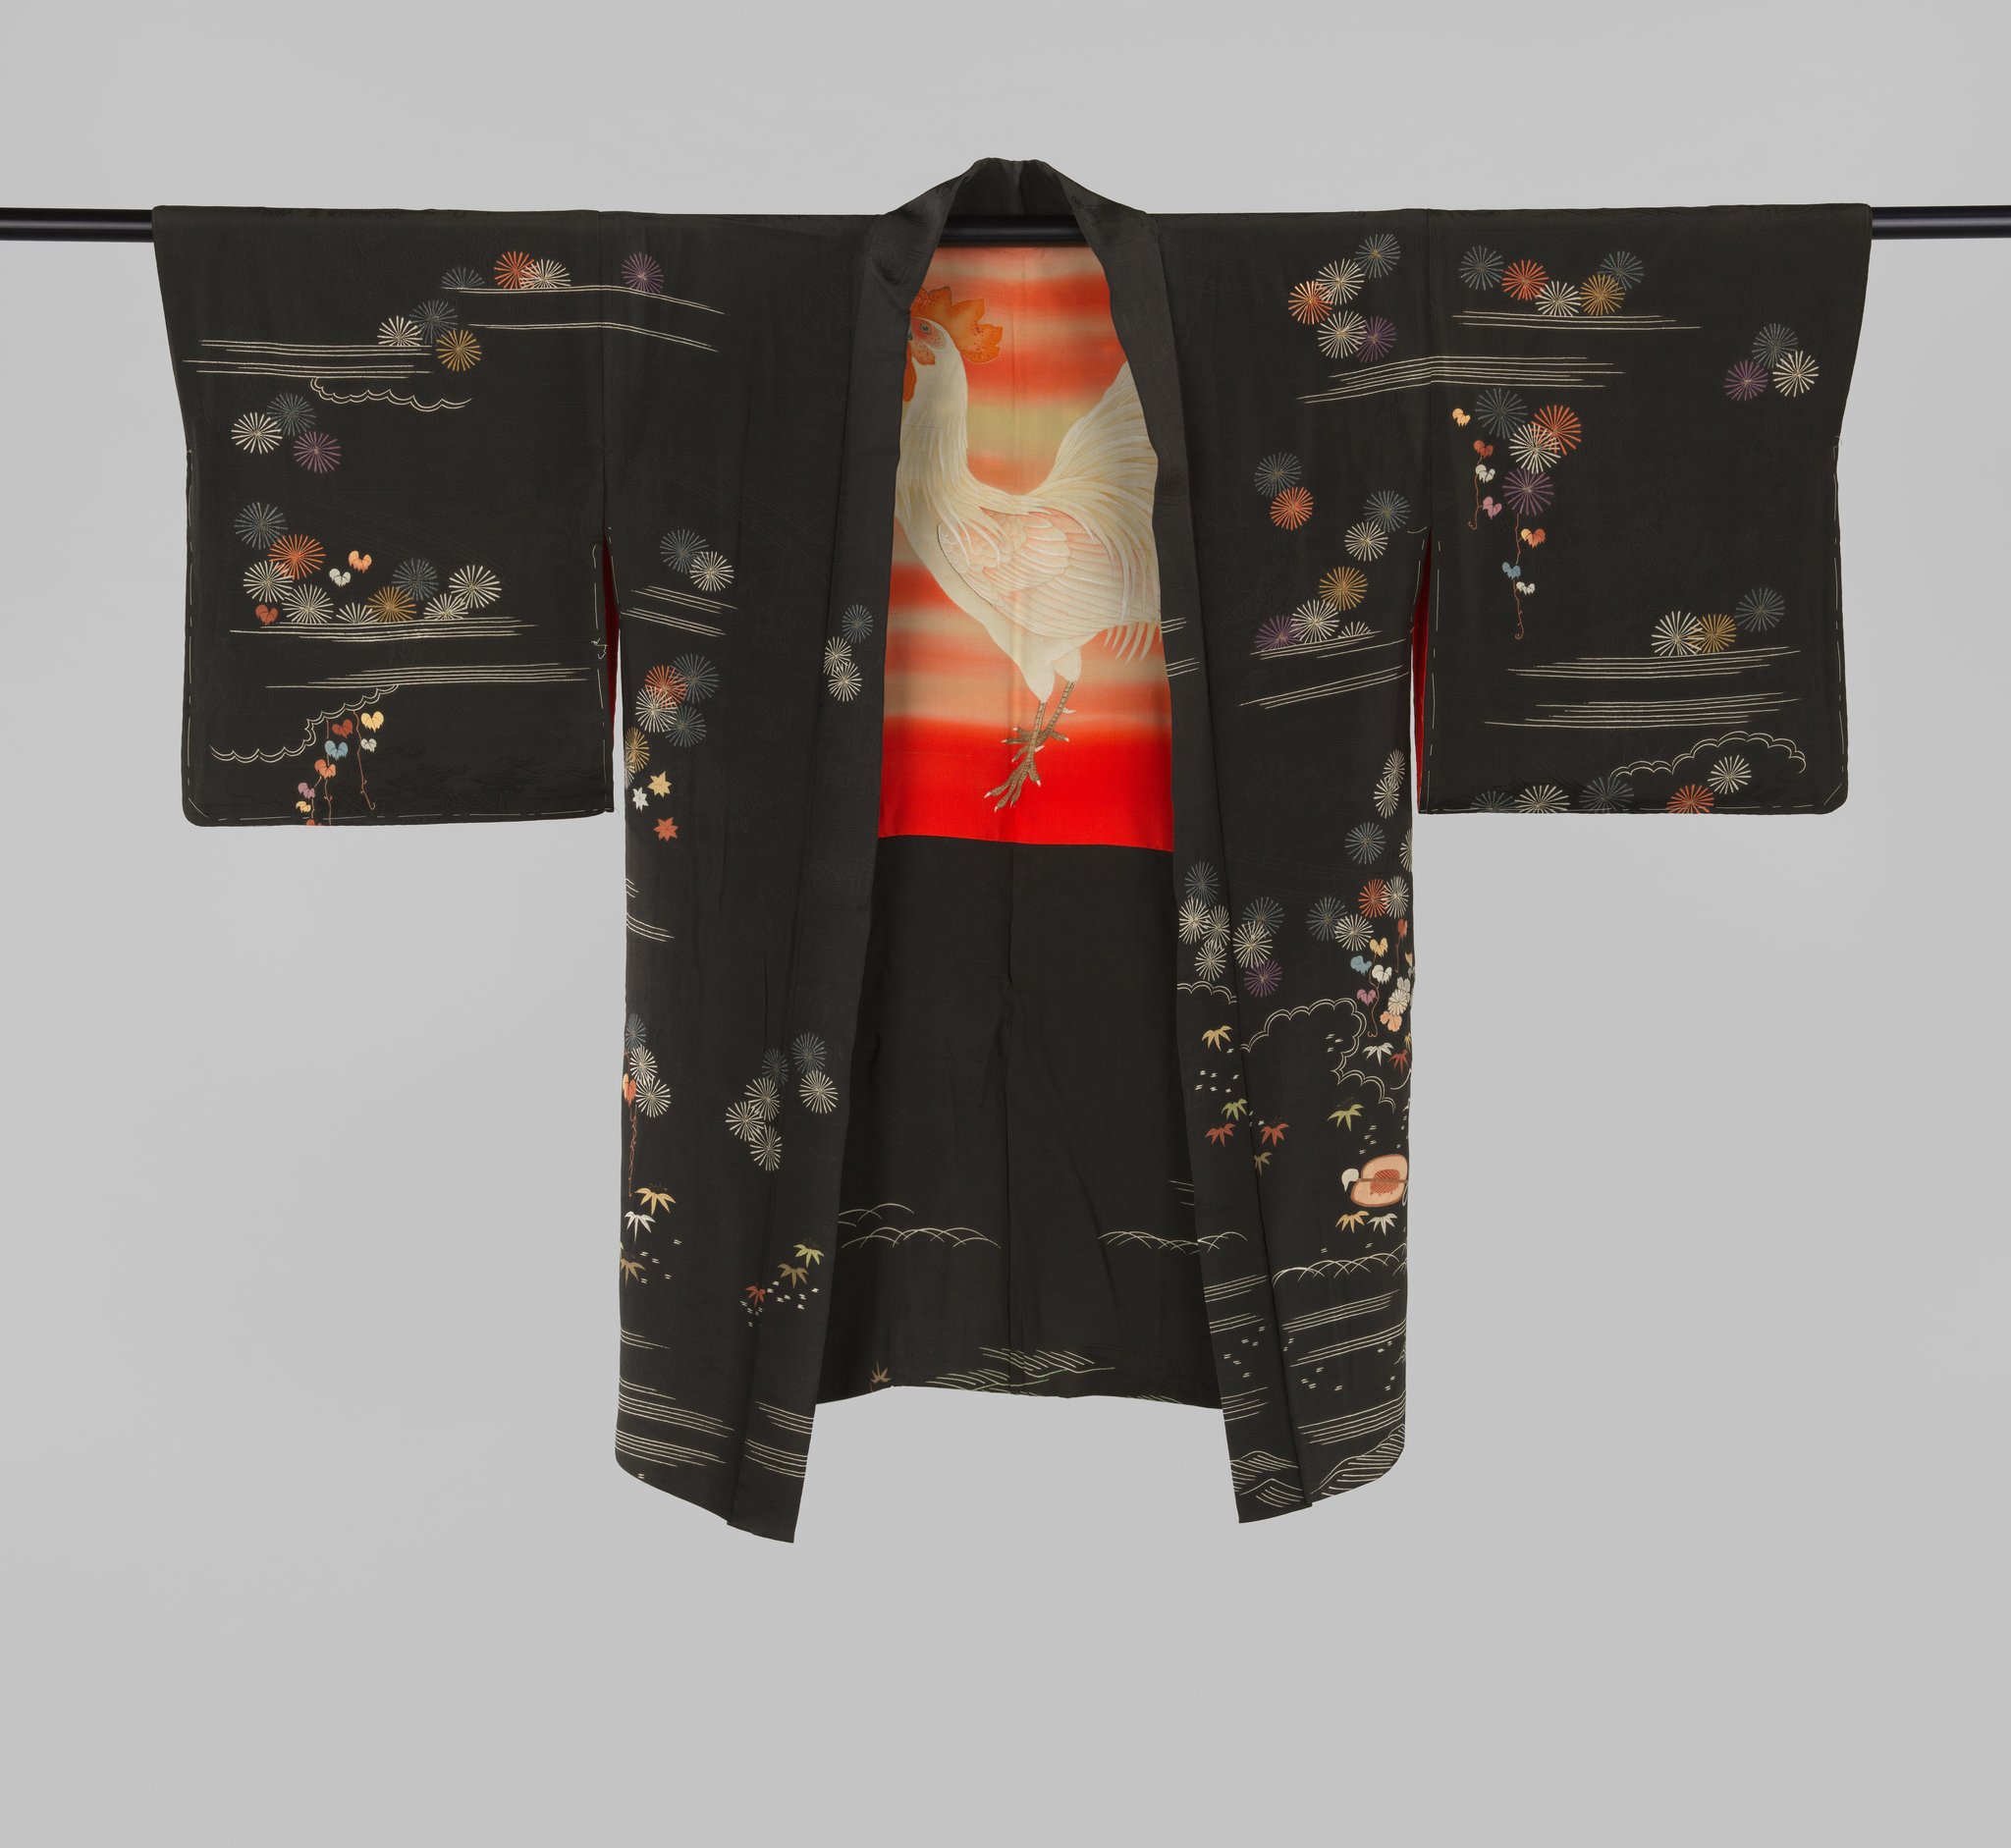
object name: kimono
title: Vrouwen haori met nachtlandschap en haan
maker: Anonymous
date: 1920-1940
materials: silk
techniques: embroidered, painting, weave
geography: japan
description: Haori voor een vrouw met een versiering over het hele vlak van een voorstelling van een ossenkar en twee dozen voor het schelpenspel, in een nachtelijk landschap met bloemen, water, rotsen en pijnboommotieven, de voering met een kraaiende haan in het ochtendgloren tegen een rode achtergrond; refererend aan afscheid de grenspost bij Osaka, waar geliefden elkaar heimelijk plachtten te ontmoeten. Het Hoofdkussenboek van Sei Shonagon: ‘Er mogen sommigen zijn die bedrogen worden door het kraaien van de haan dat vals de stilte van de nacht verbreekt, maar die misleiding zal niet opgaan voor de Grenspost bij Osaka, waar geliefden hun rendez-vous hebben.’ Zwarte fijne crêpe zijde (kinsha) met een damast geweven decoratie van , buitenkant en voering met geschilderde yuzen decoratie en geborduurde detaillering. Drie familiewapens (mon) van het ‘slangenoog-motief’ (janome).